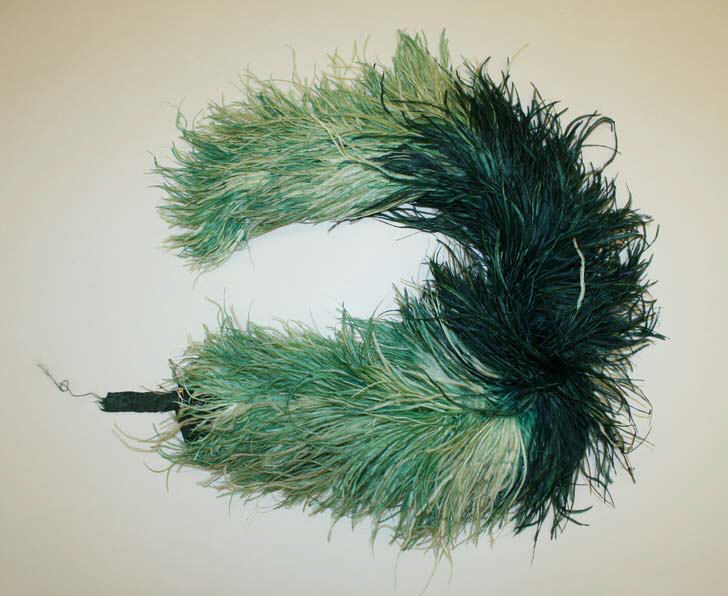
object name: neckpiece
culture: american or european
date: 1900